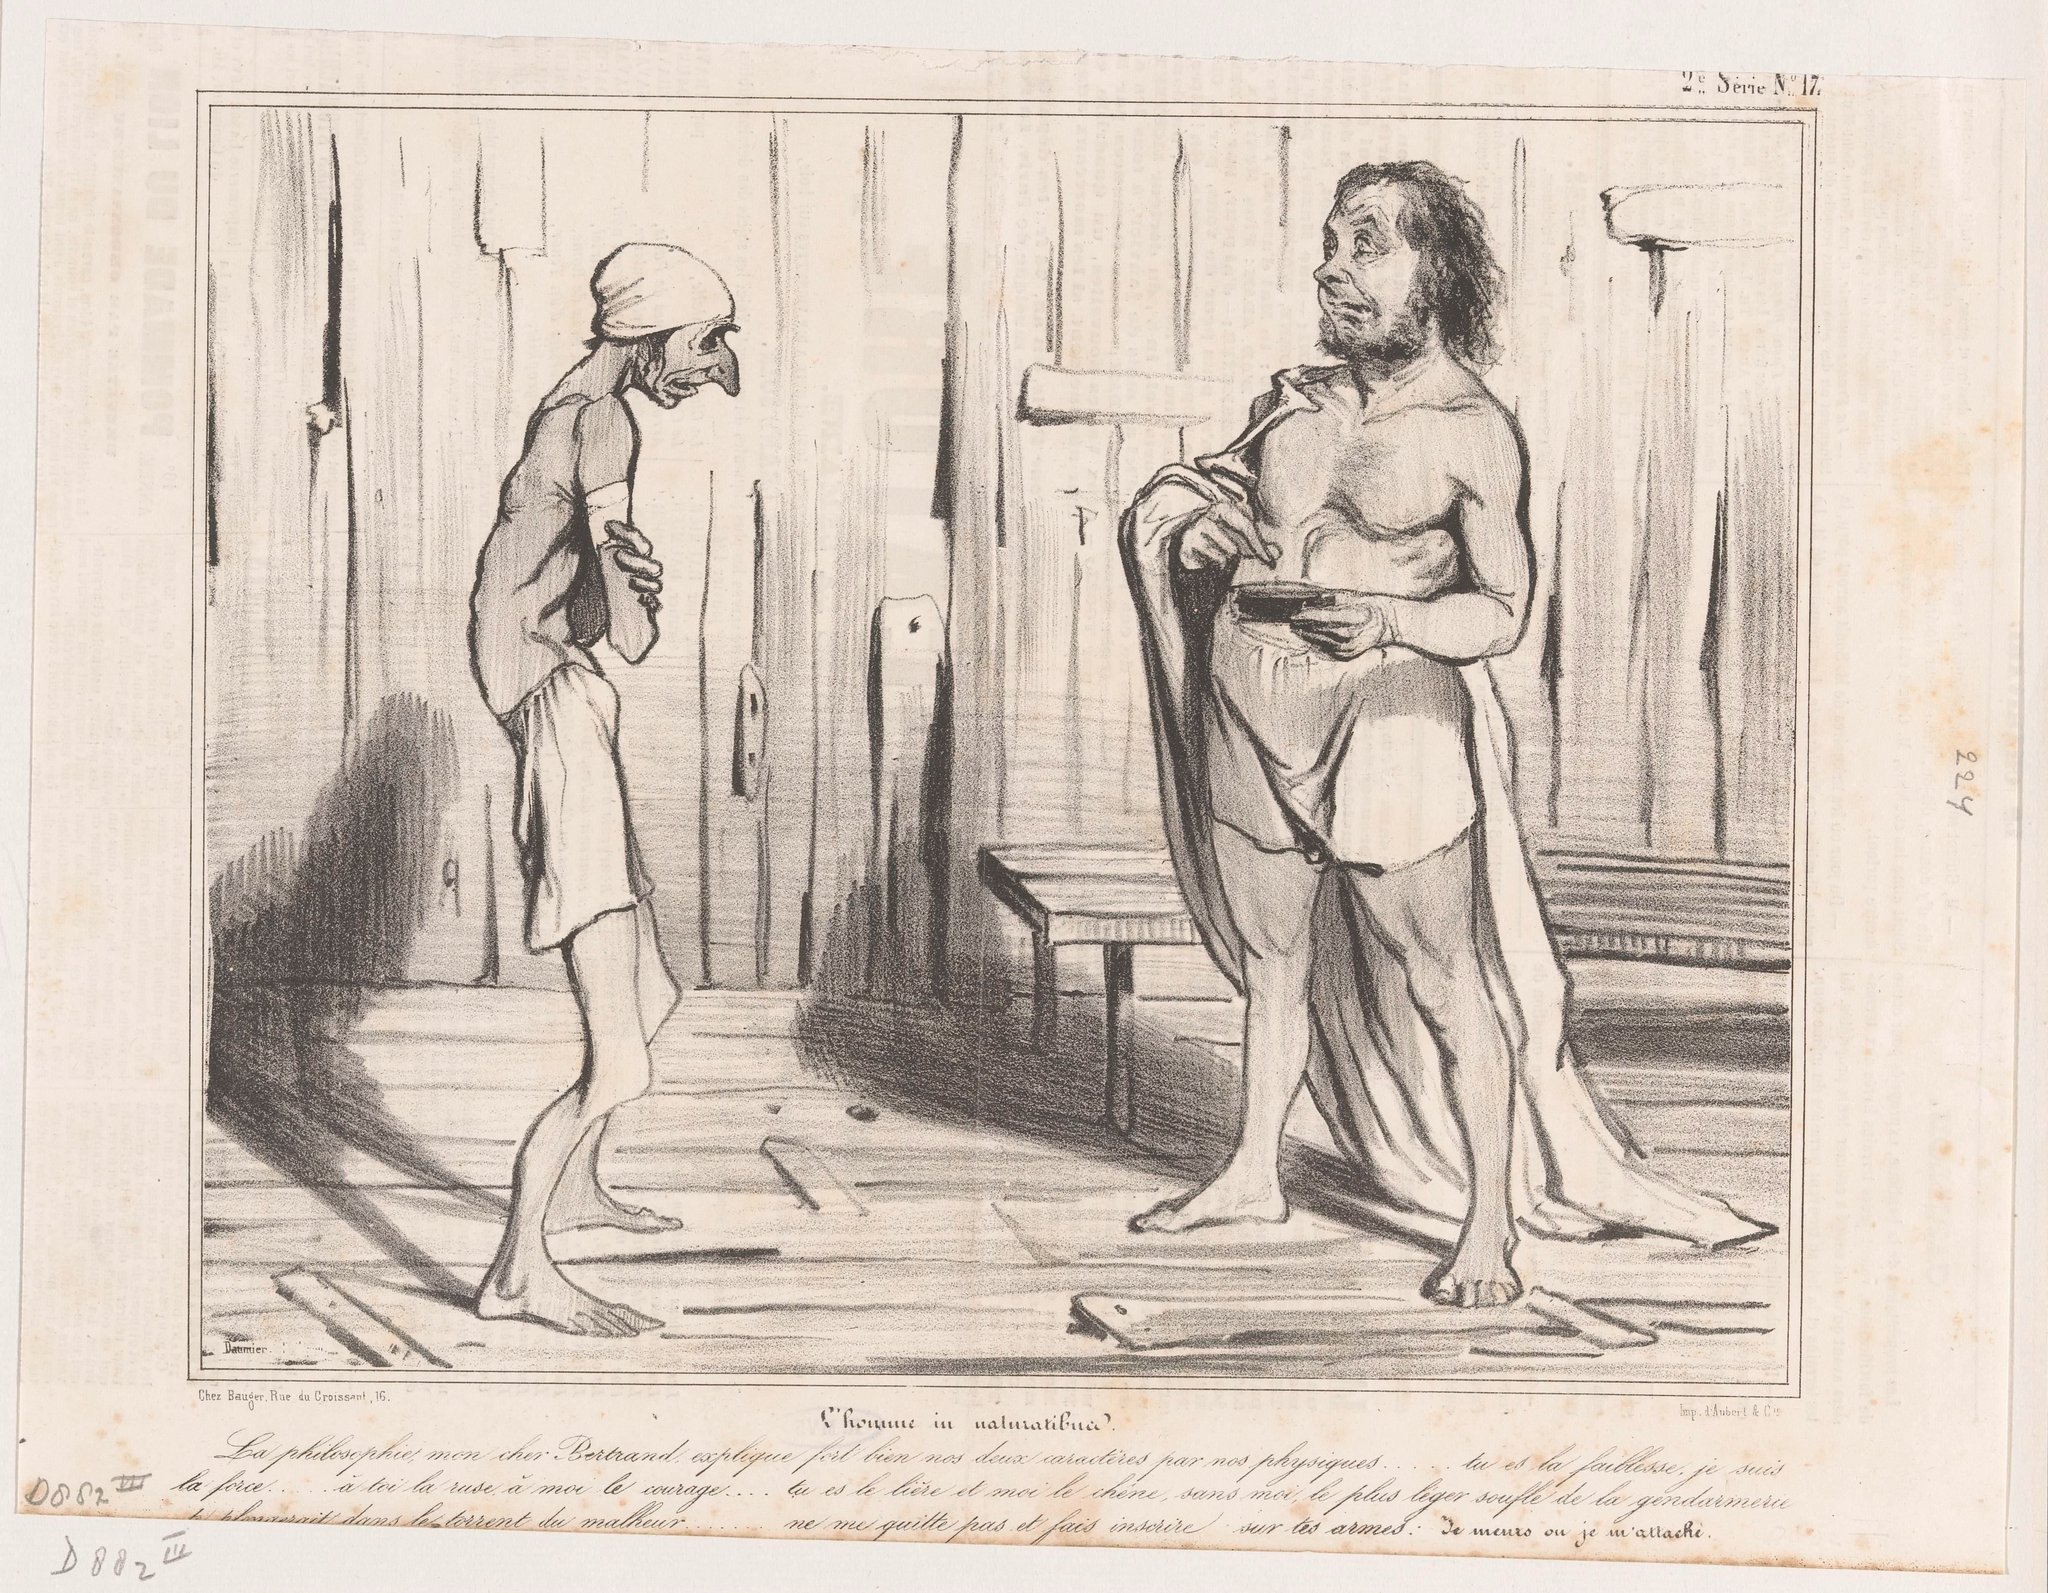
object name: cartoon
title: Robert Macaire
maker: honoré daumier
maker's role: draughtsman, painter, print maker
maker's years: 1808-1879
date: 1842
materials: paper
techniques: letterpress printing, lithograph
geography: paris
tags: caricatures (human types), public baths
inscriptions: collector's mark: Lugt 2228a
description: Prent uit: Le Charivari, 9 augustus 1842. Prent voor het eerst gebruikt in: La Caricature (3e jaar), nr. 21, 23 mei 1841.